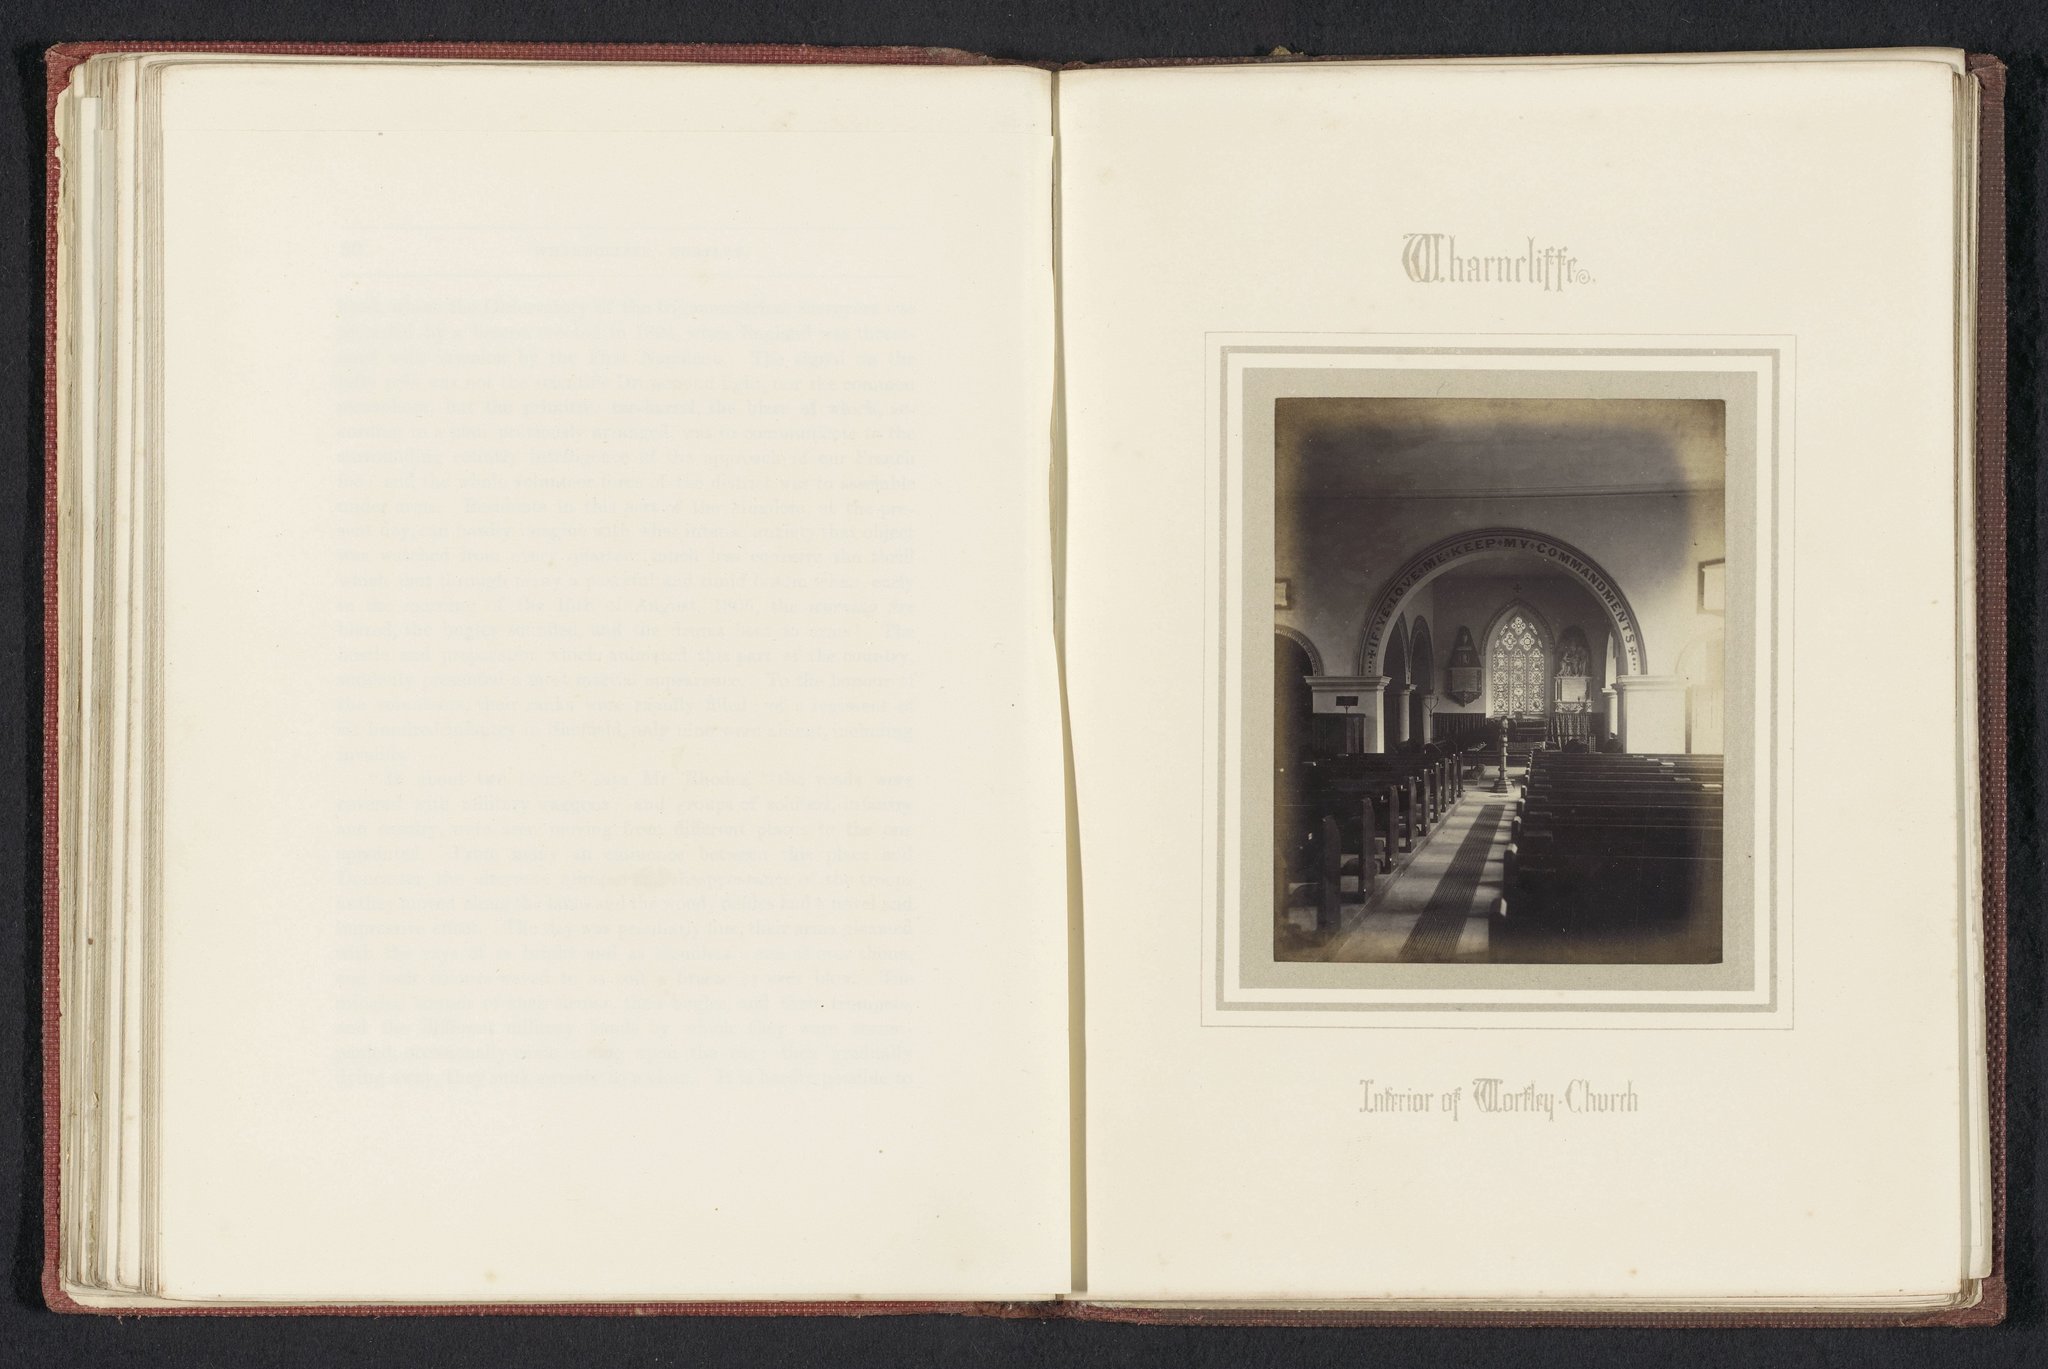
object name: page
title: Interior of Wortley Church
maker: theophilus smith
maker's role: fotograaf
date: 1854-1864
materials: photographic support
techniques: albumen print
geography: saint leonard's wortley church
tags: parts of church interior: aisle, interior of church